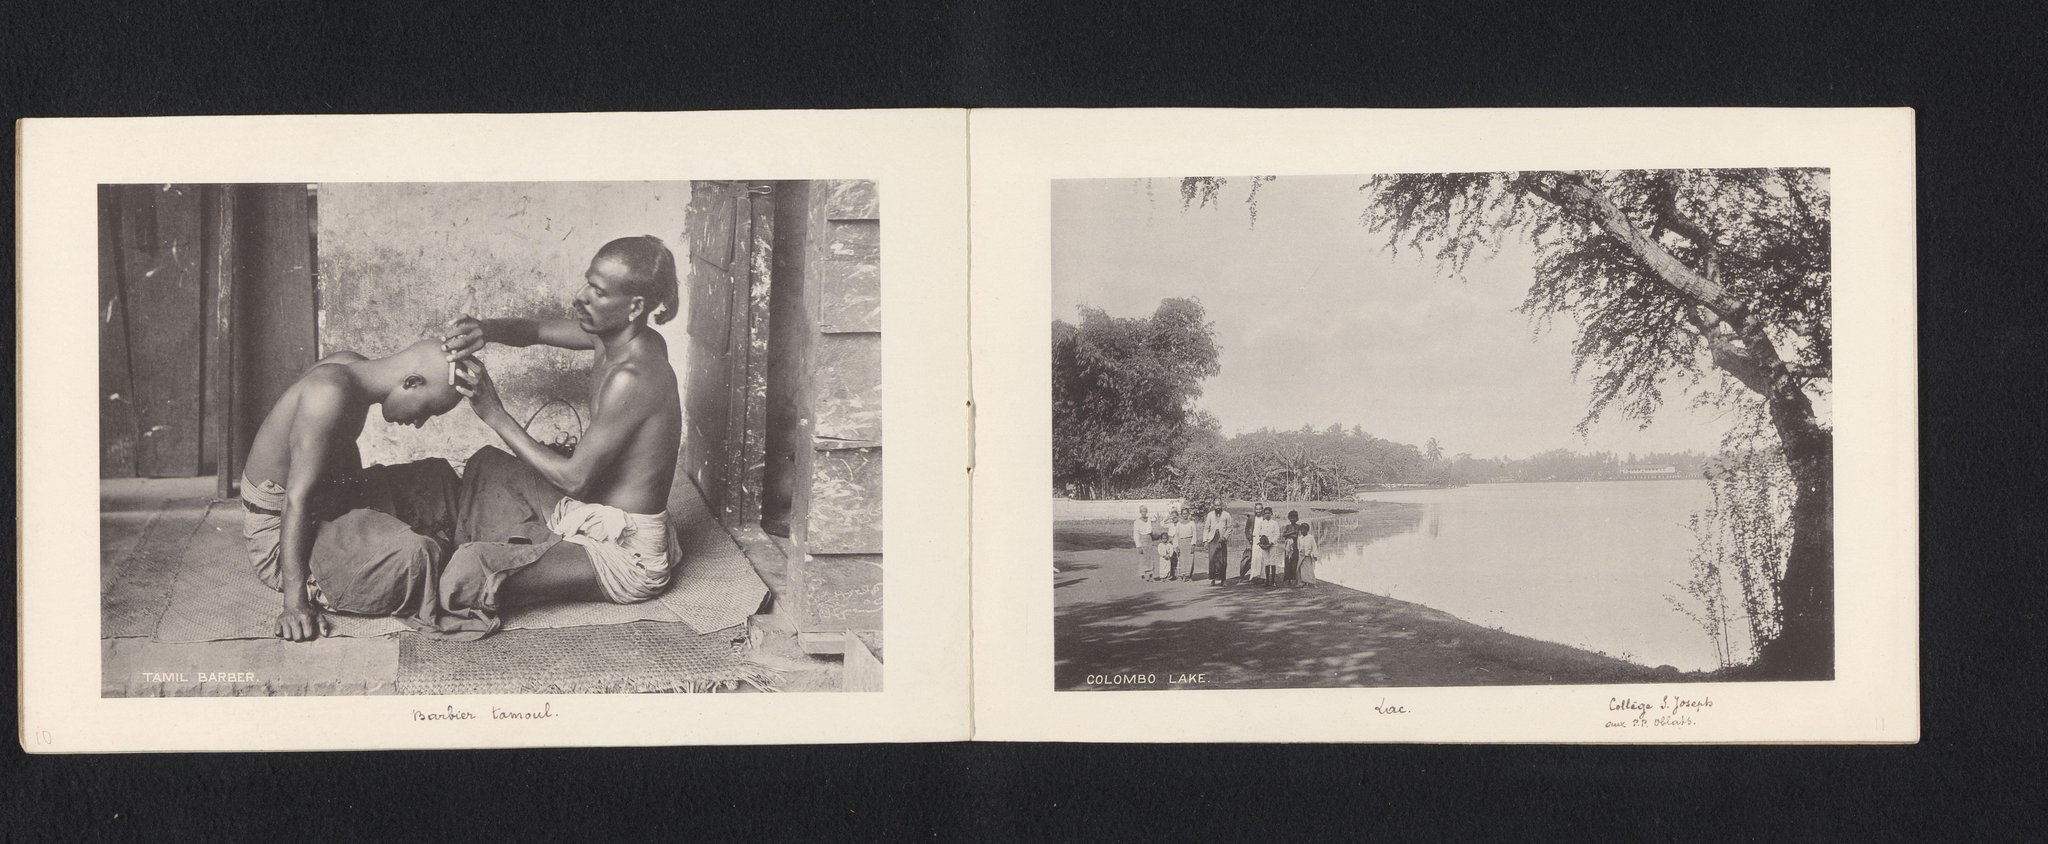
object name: photomechanical print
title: Gezicht op een kapper die het hoofd van een jonge man scheert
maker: henry william cave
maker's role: fotograaf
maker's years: 1854-1913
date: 1890-1910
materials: paper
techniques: photograph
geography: colombo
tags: shaving, being shaved, barber, barbershop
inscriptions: inscription: ‘Barbier tamoul’